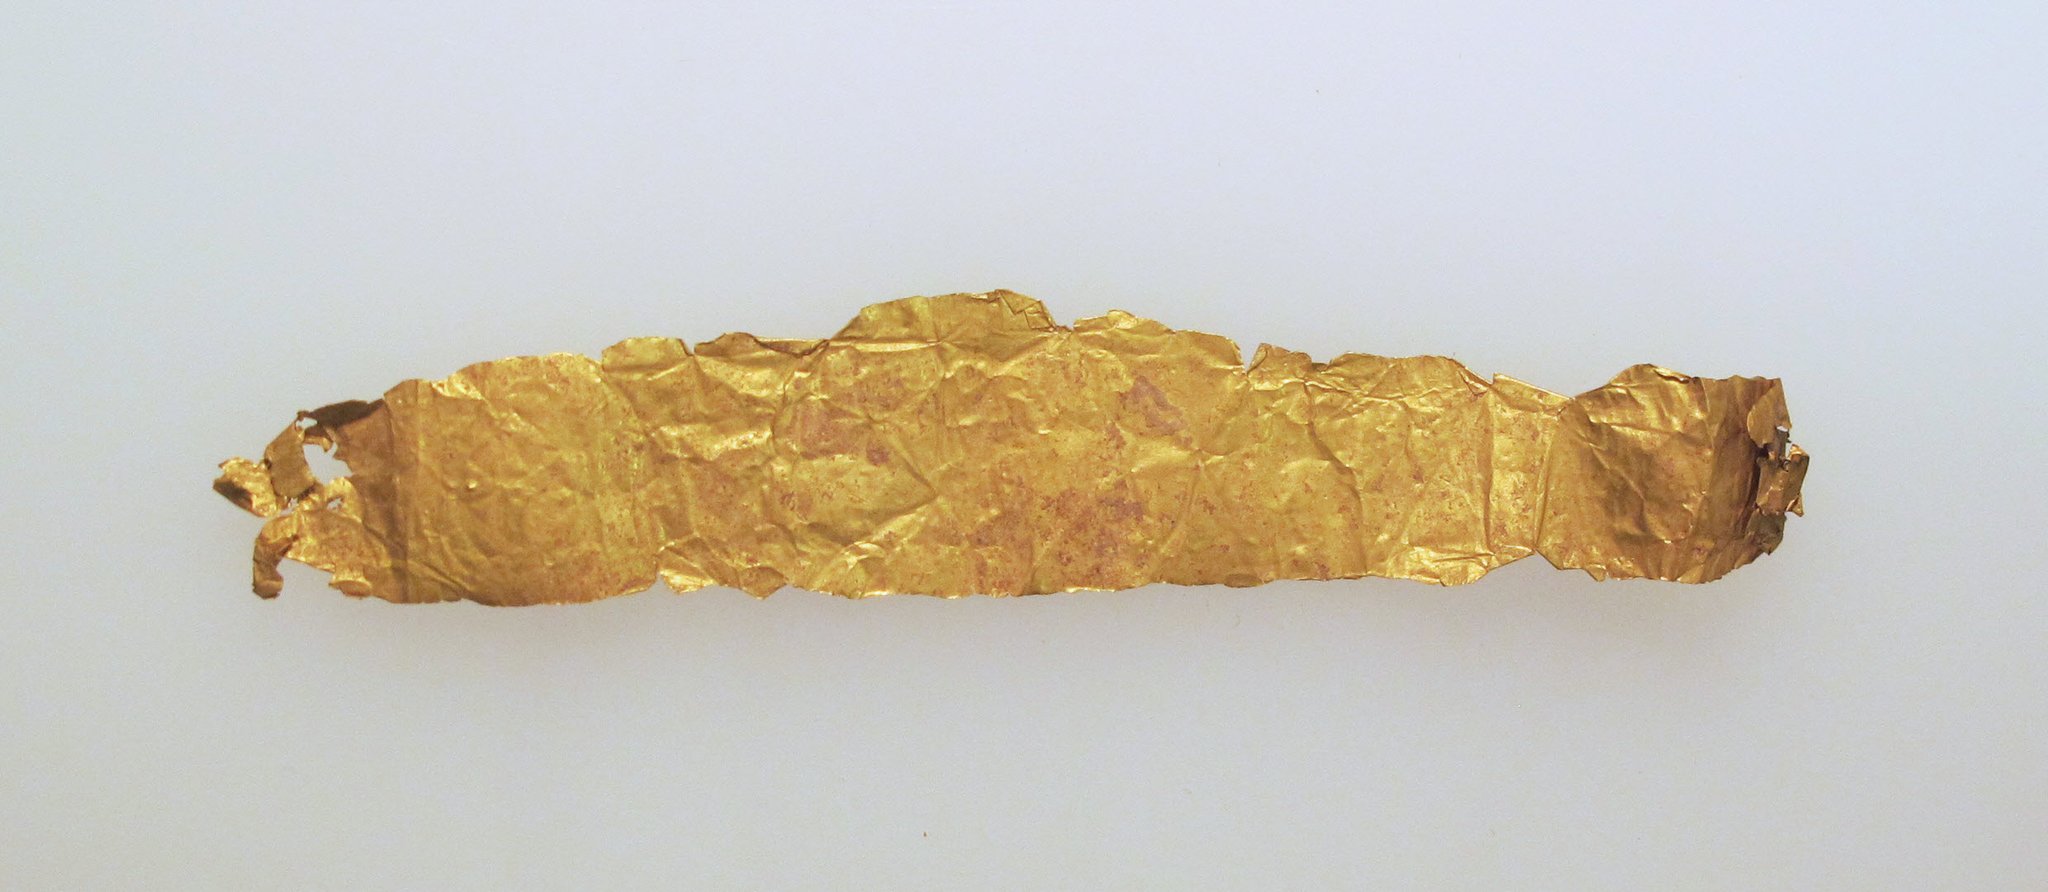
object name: frontlet of gold leaf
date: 7000 BCE-330 CE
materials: gold